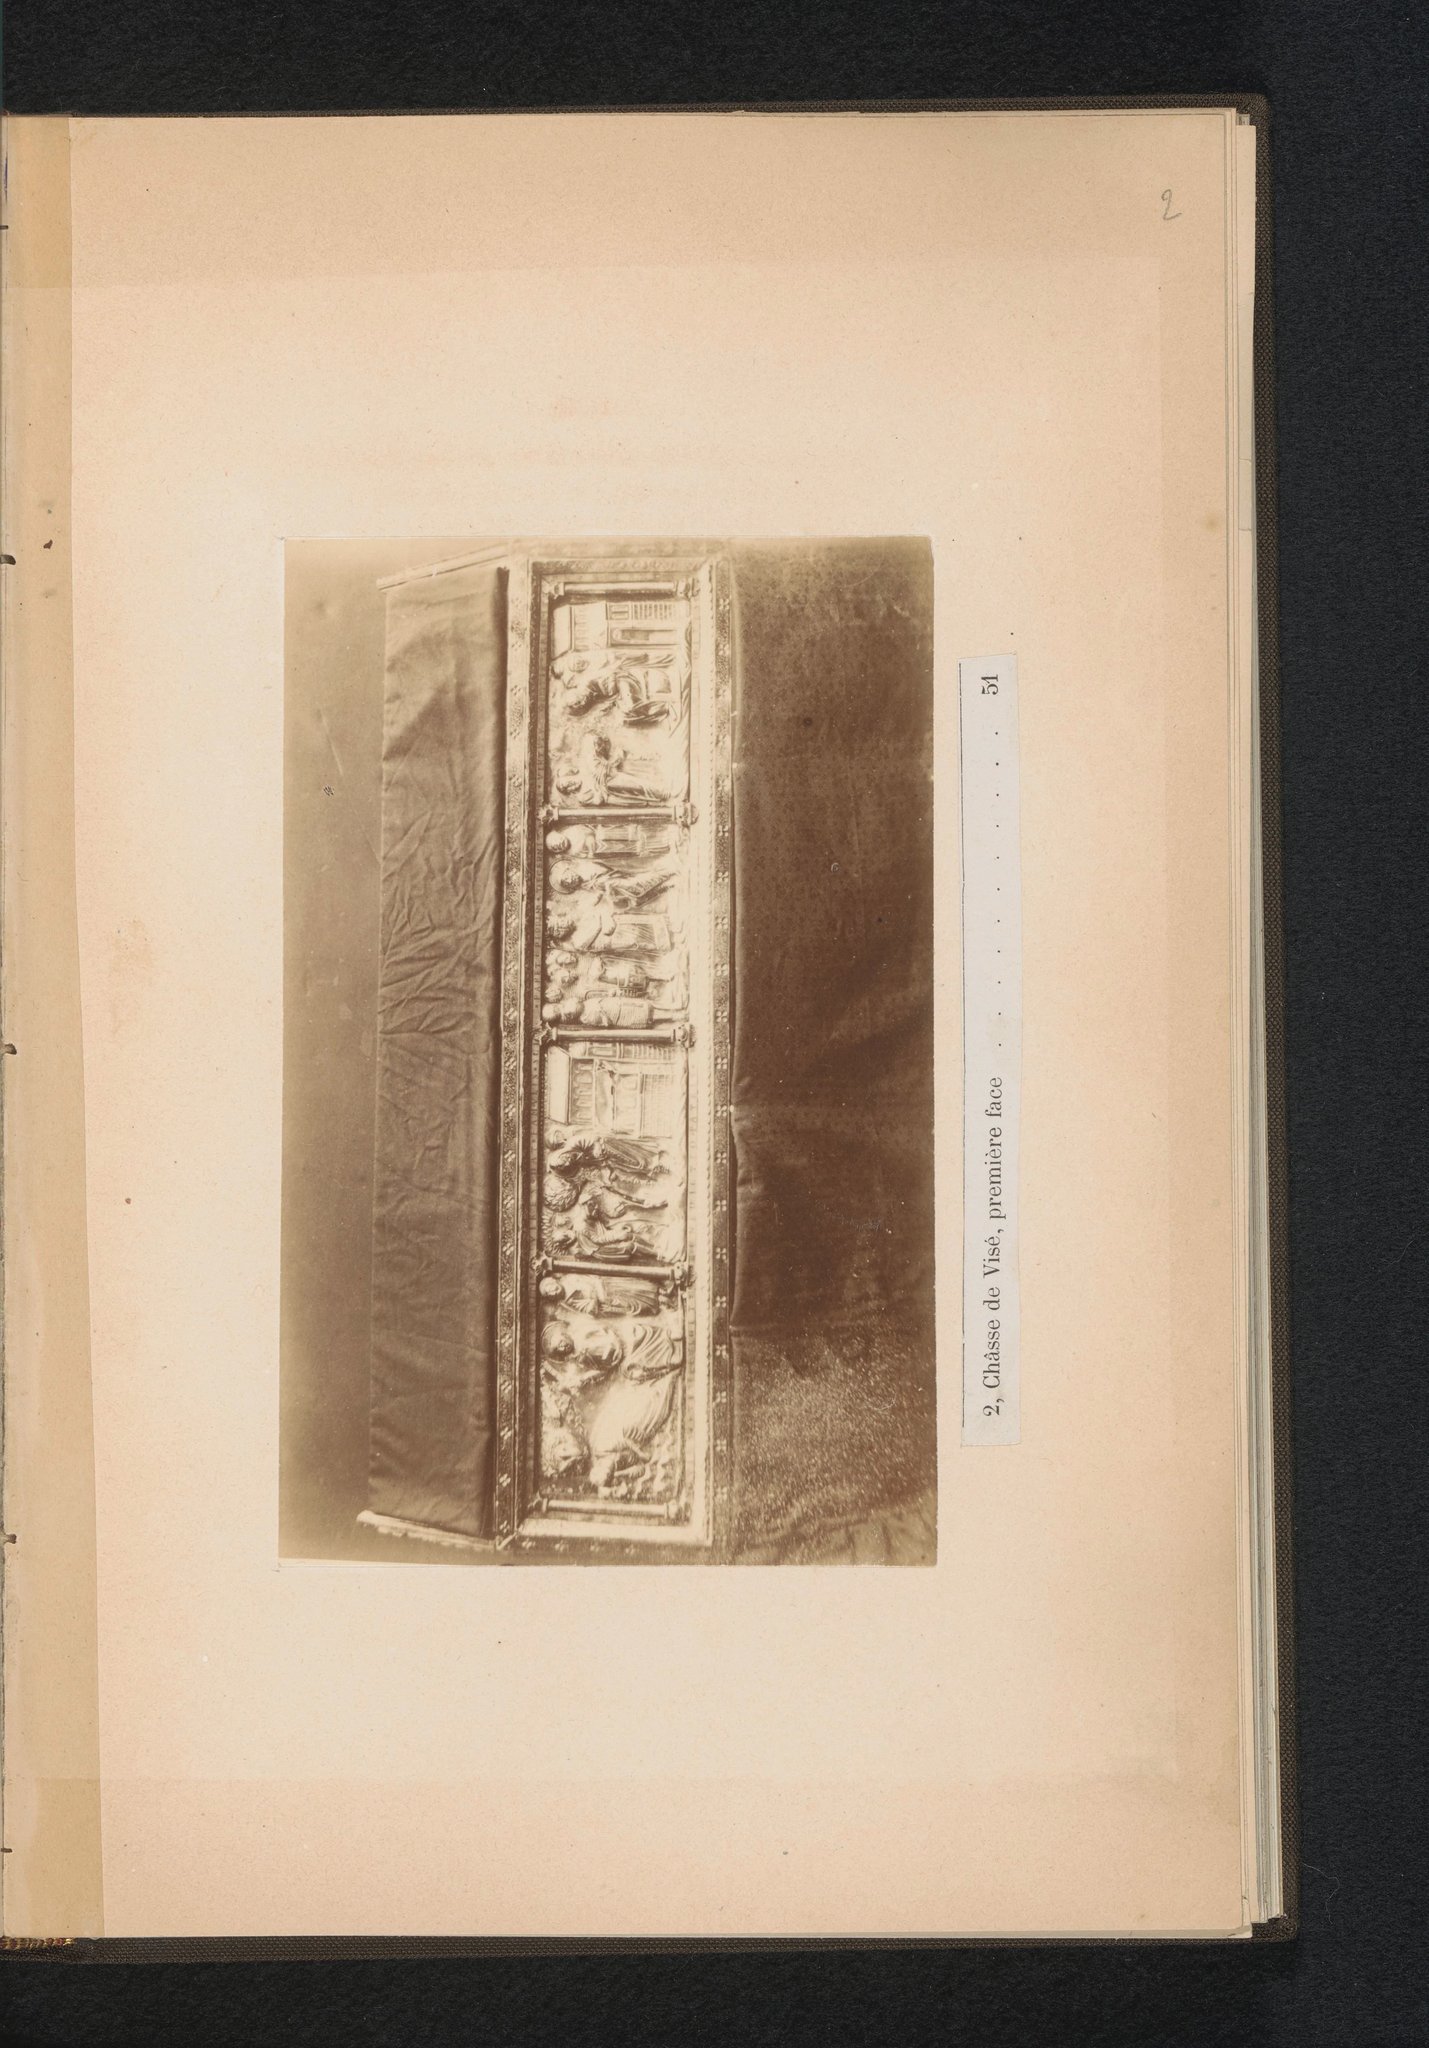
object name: photograph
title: Châsse de Visé, première face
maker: Anonymous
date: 1877-1882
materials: photographic support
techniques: albumen print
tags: holy ghost as a dove, relics (and reliquaries), sculpture (+ relief ~ sculpture)